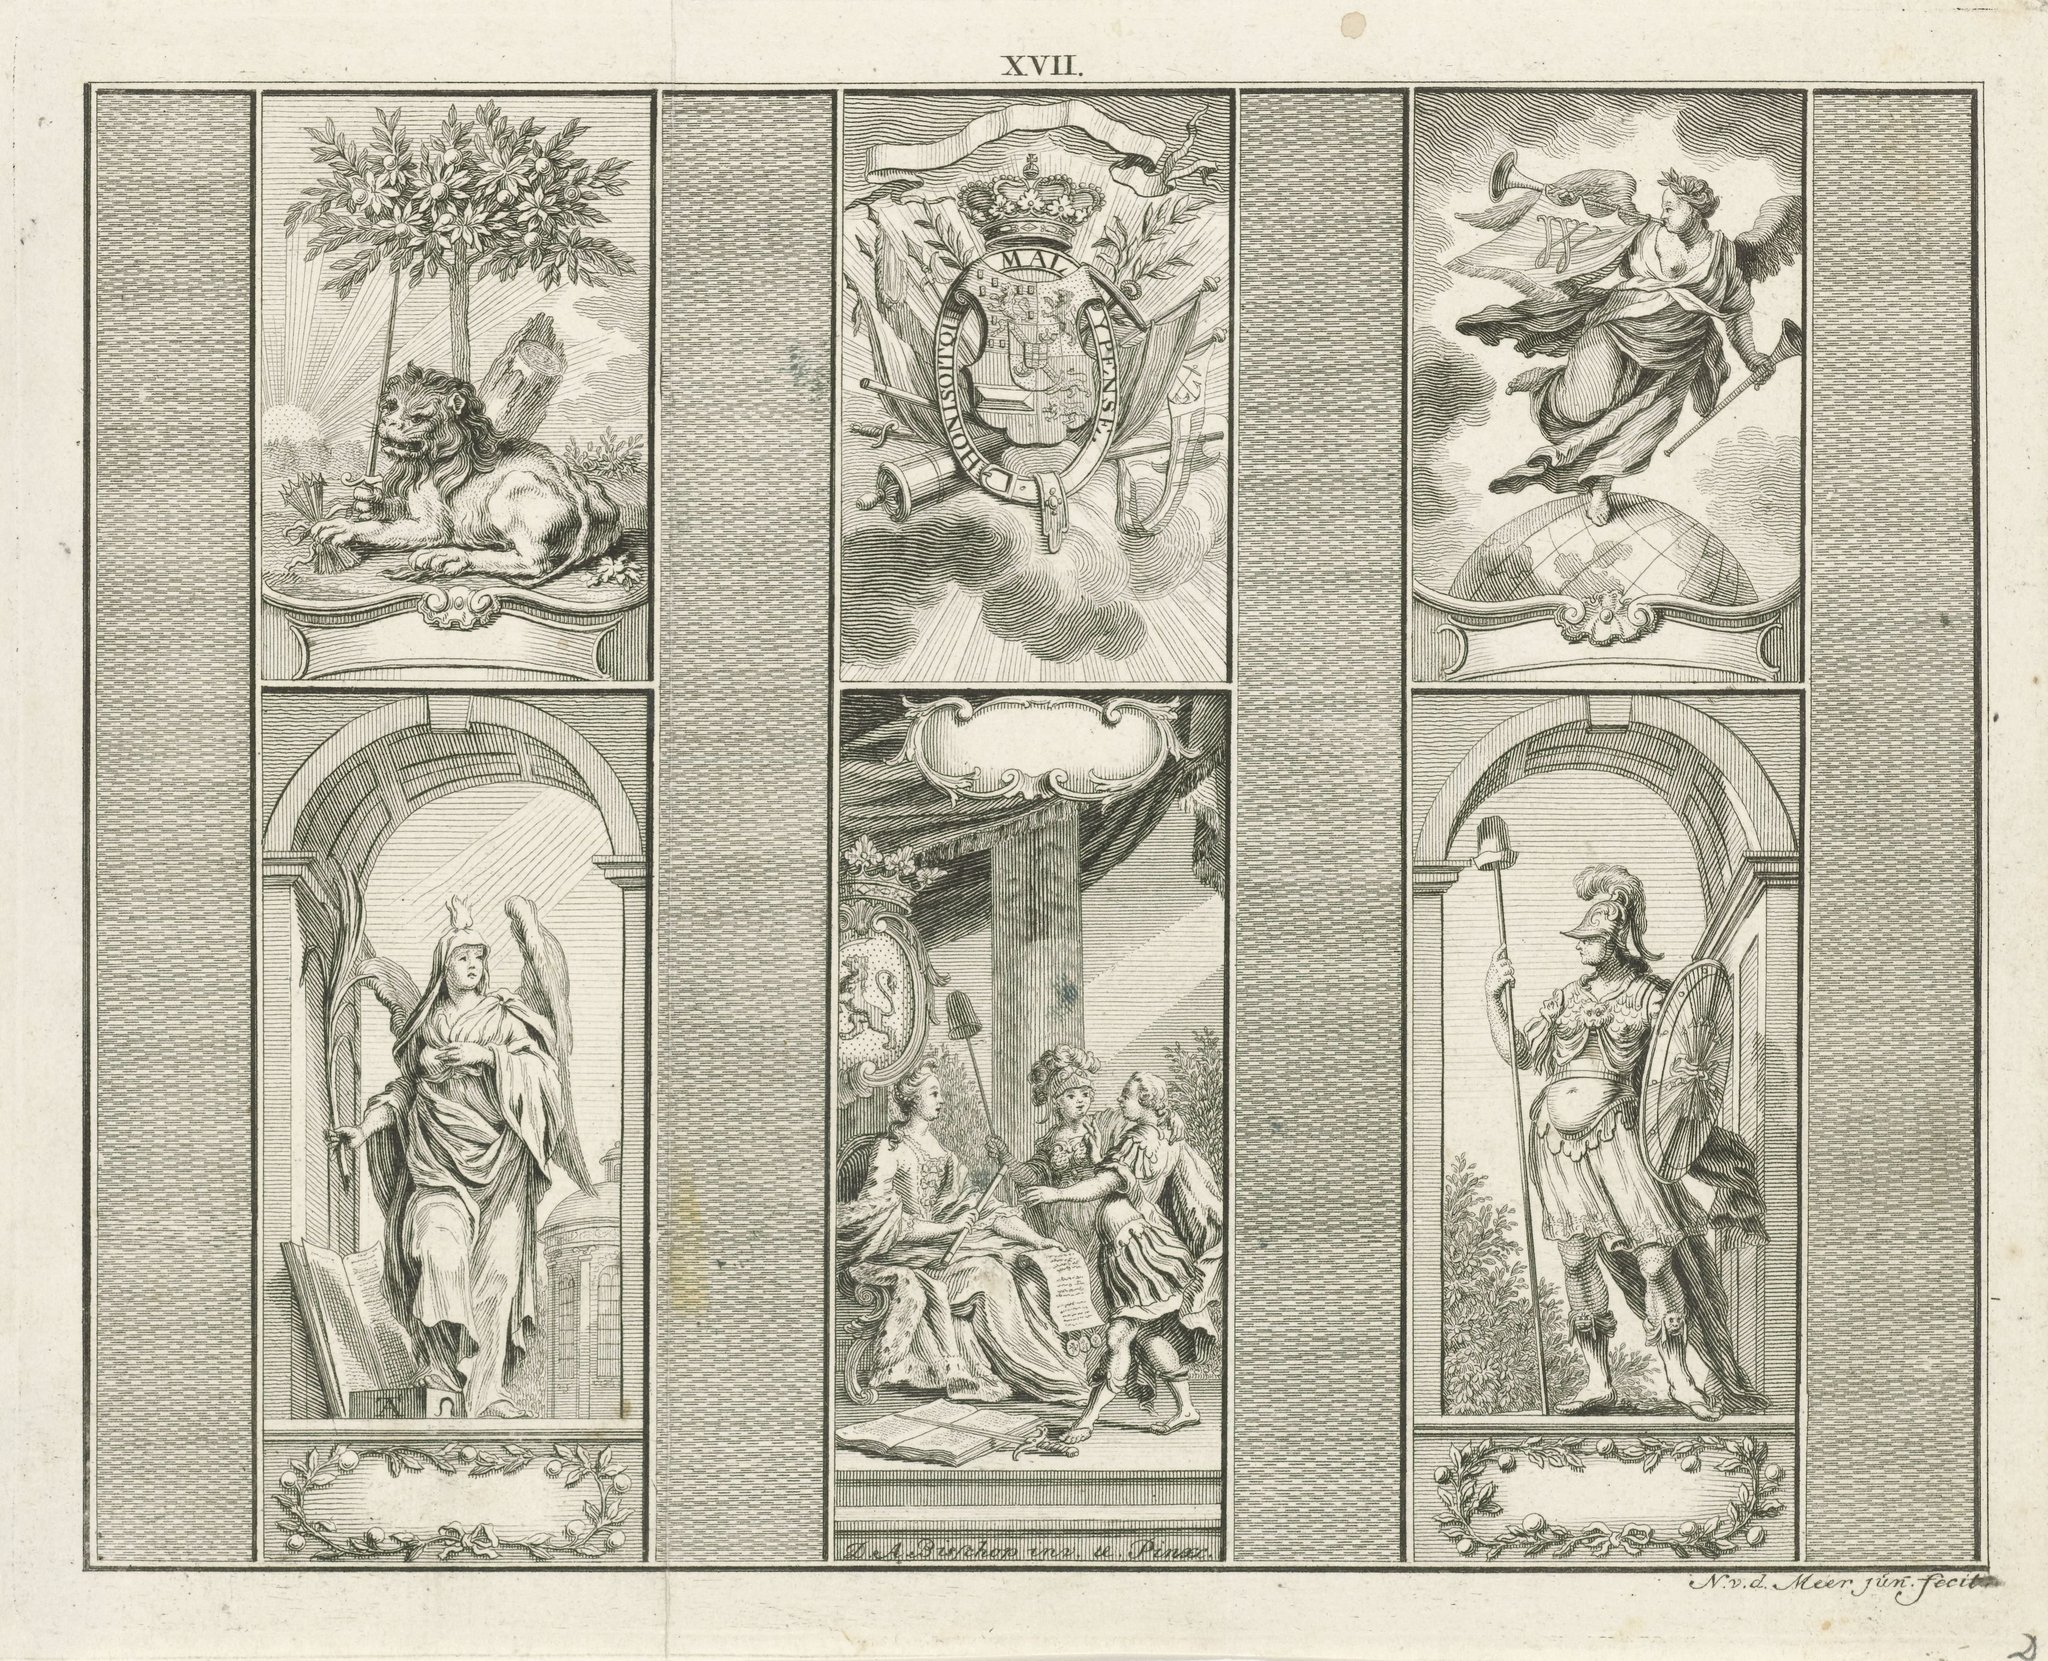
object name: book illustration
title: Decoraties bij het huis van de heer Bisschop te Rotterdam, 1766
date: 1776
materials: paper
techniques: etching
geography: amsterdam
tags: the hague, william v (prince of orange), faith, 'fides'; 'fede', 'fede catholica', 'fede christiana', 'fede christiana catholica' (ripa) ~ one of the three theological virtues, strength, power; 'fortezza', 'fortezza d'animo e di corpo', 'fortezza del corpo congiunta con la generosità dell'animo', 'fortezza & valore del corpo congiunto con la prudenza & virtù del animo', 'forza' (ripa), swearing an oath (with two fingers raised), repute, renown; 'splendore del nome' (ripa)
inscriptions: collector's mark: Lugt 2228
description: Decoraties aangebracht bij het huis van de heer Dirk Anthony Bisschop te Rotterdam. Zes panelen met allegorische voorstellingen en emblemen. Linksboven de Hollandse Leeuw met de pijlenbundel en het zwaard, midden boven het wapenschild van Willem V. Rechtsboven de Faam met een banier met de letter W. Linksonder de personificatie van het Geloof en rechtonder de Kracht. Midden onder de Hollandse Maagd op een troon en Willem V, die een gelofte aflegd. Ter gelegenheid van de meerderjarigheid van prins Willem V op 8 maart 1766. Genummerd bovenaan: XVII.